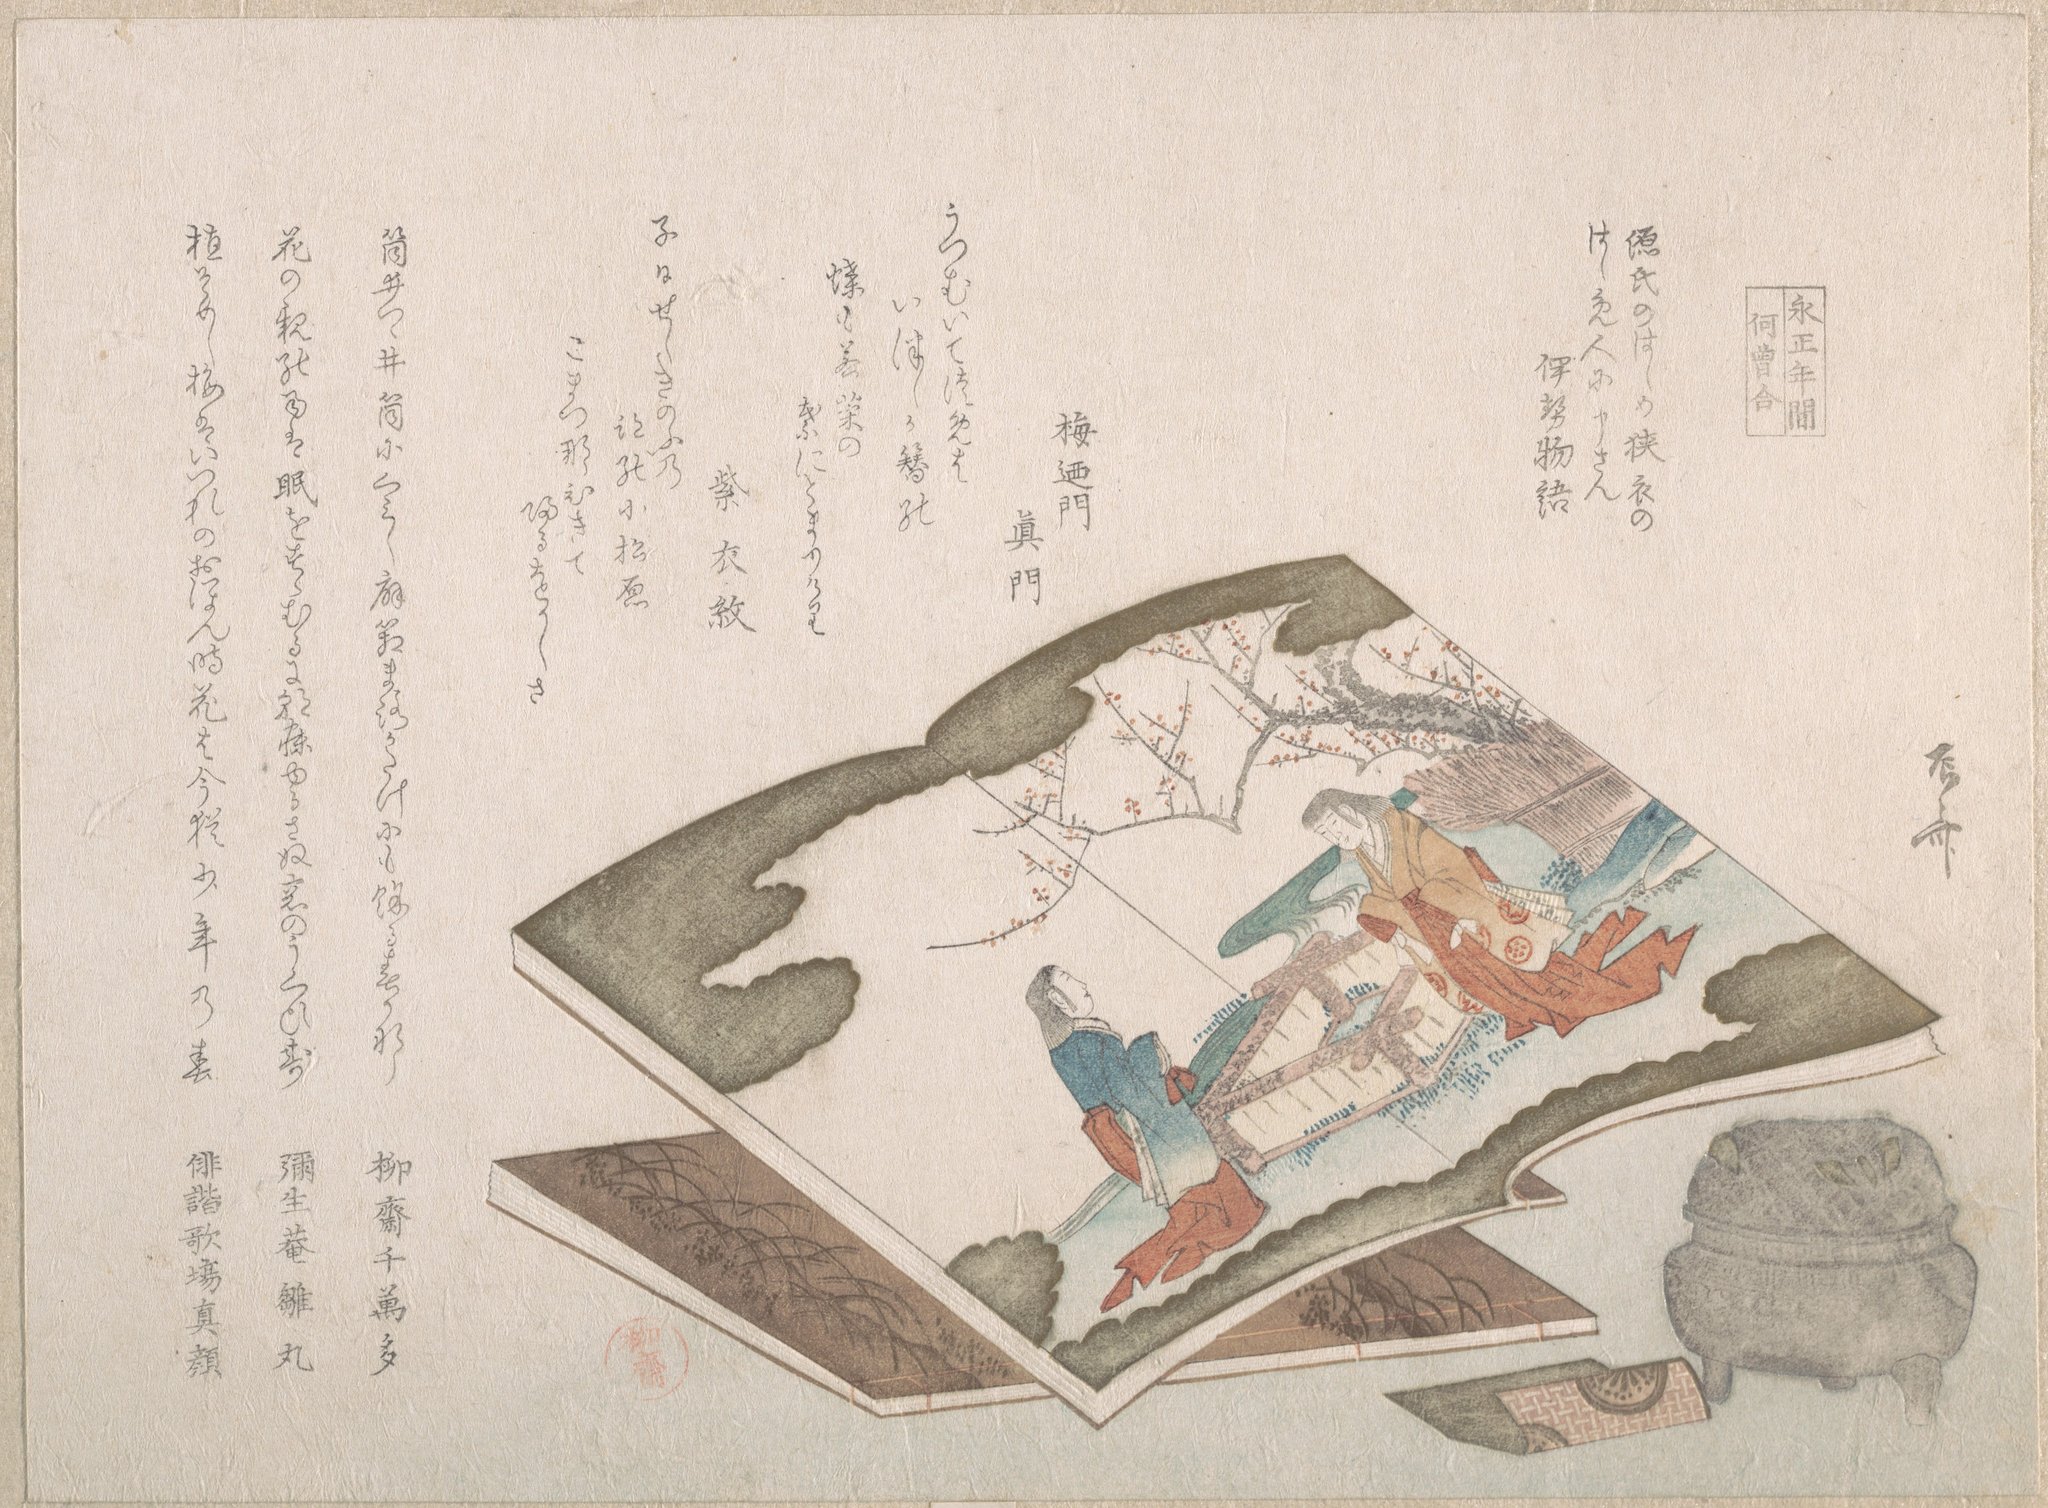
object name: woodblock print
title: Illustrated Books and an Incense Burner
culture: japanese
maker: ryūryūkyo shinsai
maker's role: artist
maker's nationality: japanese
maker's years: 1799-1823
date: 1801-1900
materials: ink, paper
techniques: surimono, woodblock print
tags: books,incense burners